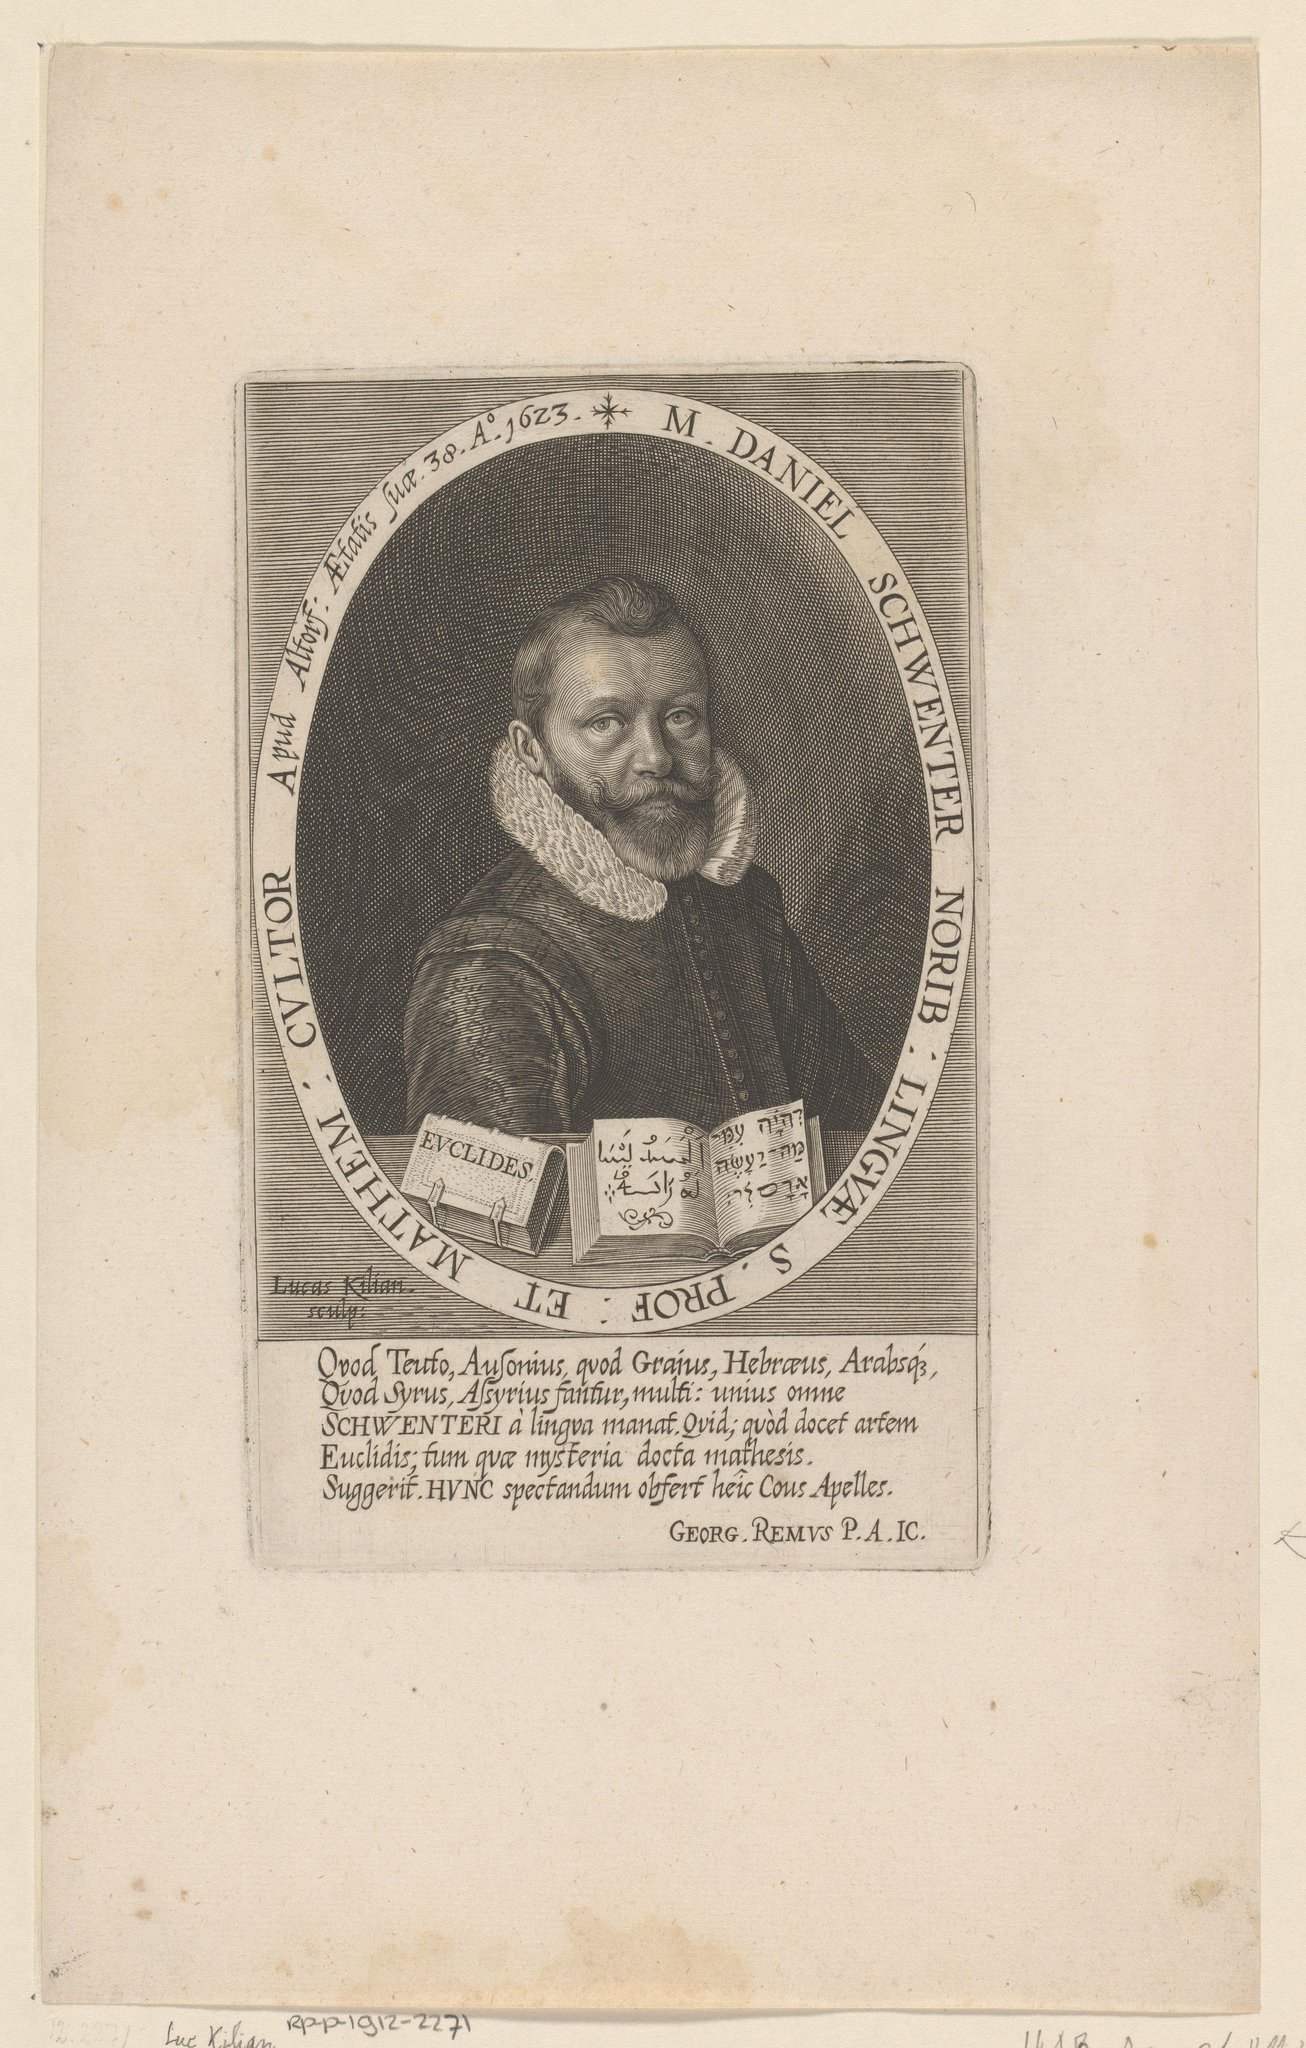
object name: print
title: Portret van Daniel Schwenter op 38-jarige leeftijd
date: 1623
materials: paper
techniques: engraving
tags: further education (+ portrait of teacher, professor), ethnology, cultural anthropology (+ portrait of scholar, scientist), historical persons, mathematics (+ portrait of scholar, scientist)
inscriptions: collector's mark: Lugt 2228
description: Met vijfregelig onderschrift in het Latijn en tekst in het Latijn rondom het portret.